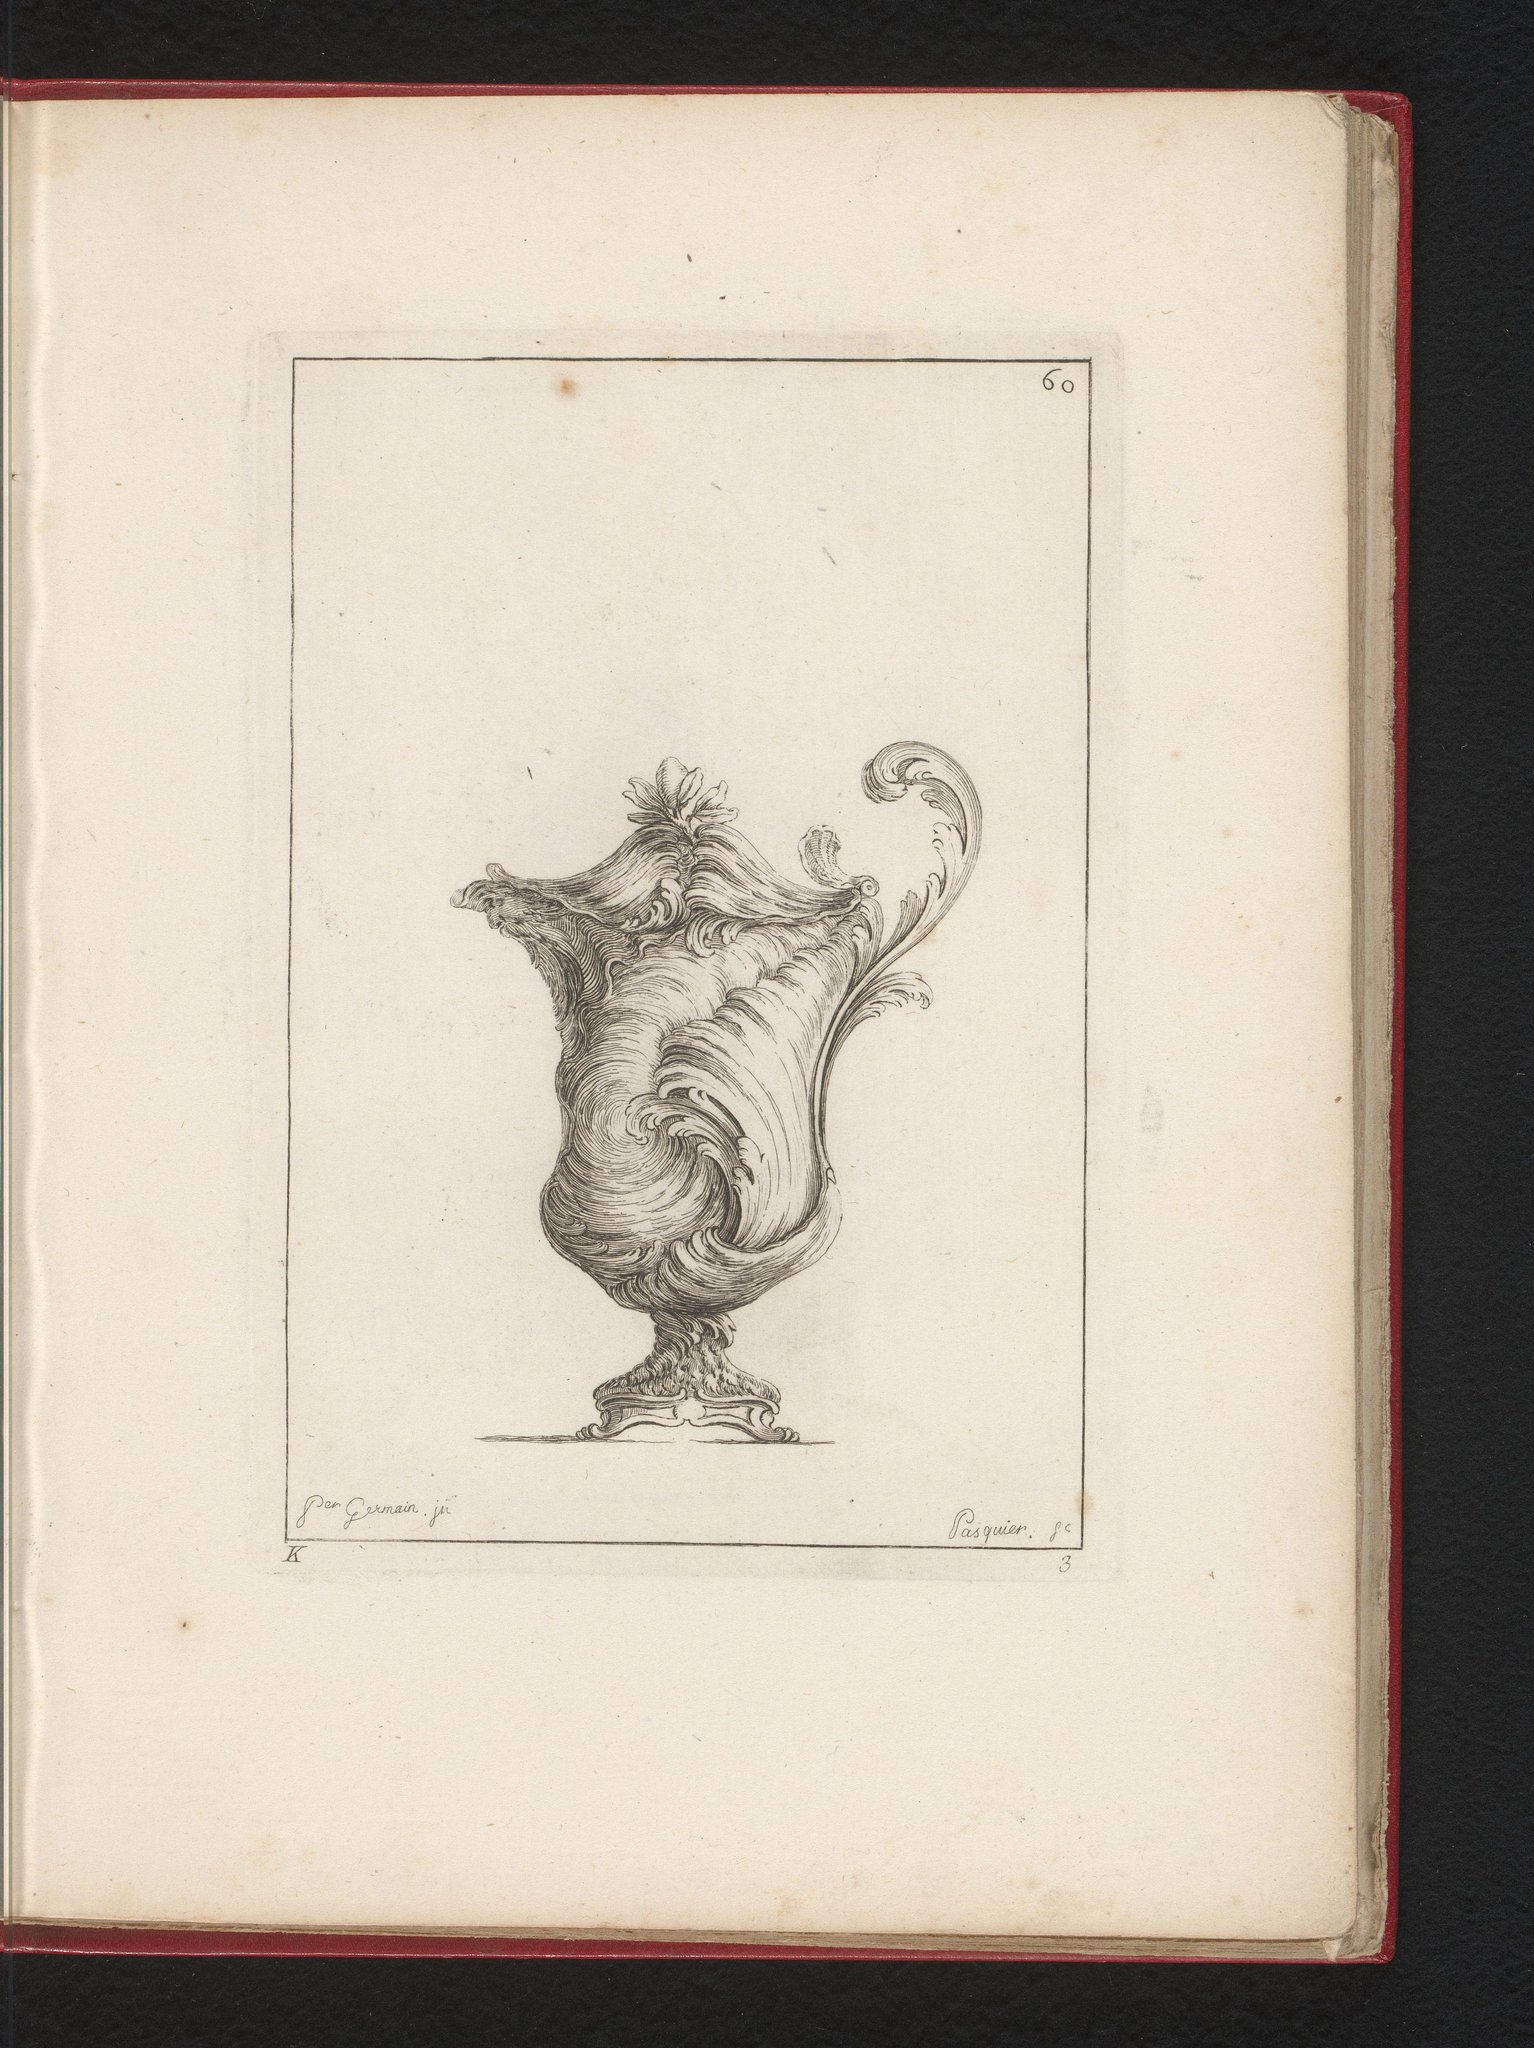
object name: print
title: Zilverwerk en edelsmeedkunst, tweede deel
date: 1748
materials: paper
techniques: etching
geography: paris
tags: mustard (+ foodstuffs in other container, e.g.: barrel, can, cask, tin, etc.)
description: Een aantal van de objecten in deze reeks heeft een eigen ondertitel, die verwijst naar genummerde 'cahiers' (afleveringen) waarin de prenten werden uitgegeven. Het is onduidelijk welke objecten recies bij welke aflevering horen. Daarom is die ondertitel enkel verwerkt bij de prent waarop die voorkomt.